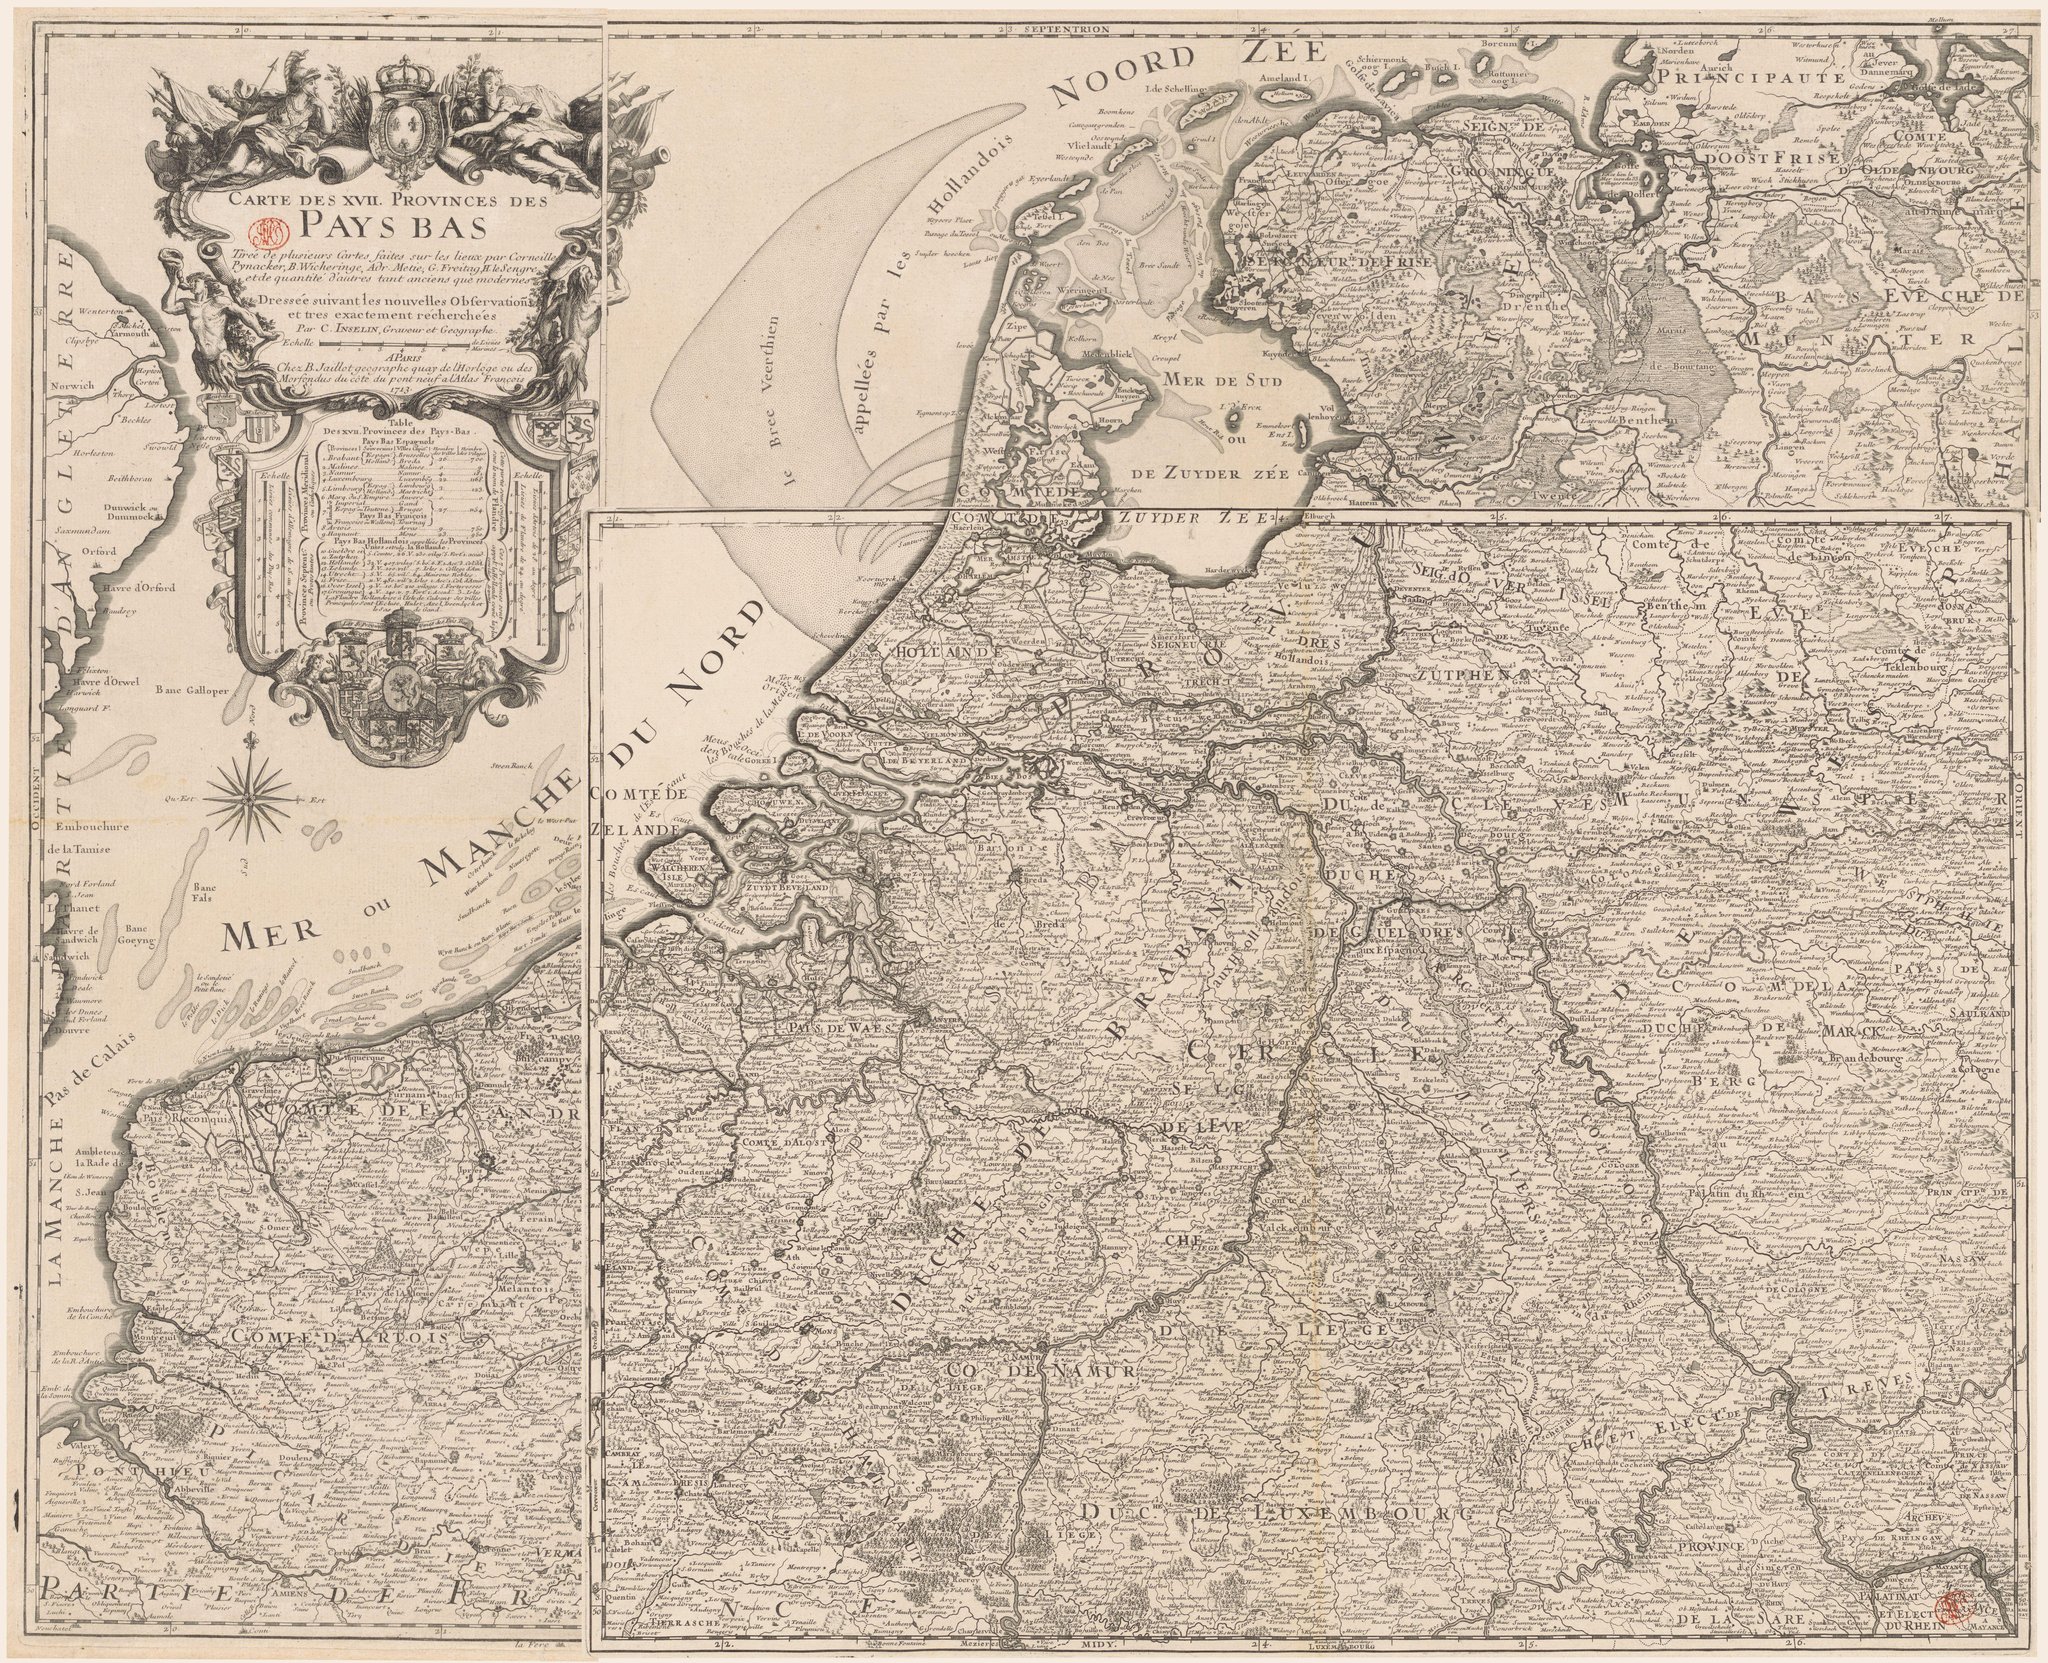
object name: map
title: Kaart van de Zeventien Provinciën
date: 1713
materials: paper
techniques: engraving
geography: paris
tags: maps of separate countries or regions, low countries, belgium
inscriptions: collector's mark: Lugt 2228, collector's mark: Lugt 195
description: Kaart van de Zeventien Provinciën. Rond de cartouche het wapen van Frankrijk en de zeventien provinciewapens. Eronder een tabel met de provincienamen en het aantal steden en dorpen per provincie. Links en rechts van de tabel vier verticale schaalstokken: Lieües d’Allemagne, Lieües communes des Pays Bas, Lieües de Flandre en Lieües d'Artois. De kaart is voorzien van een gradenverdeling langs de randen.